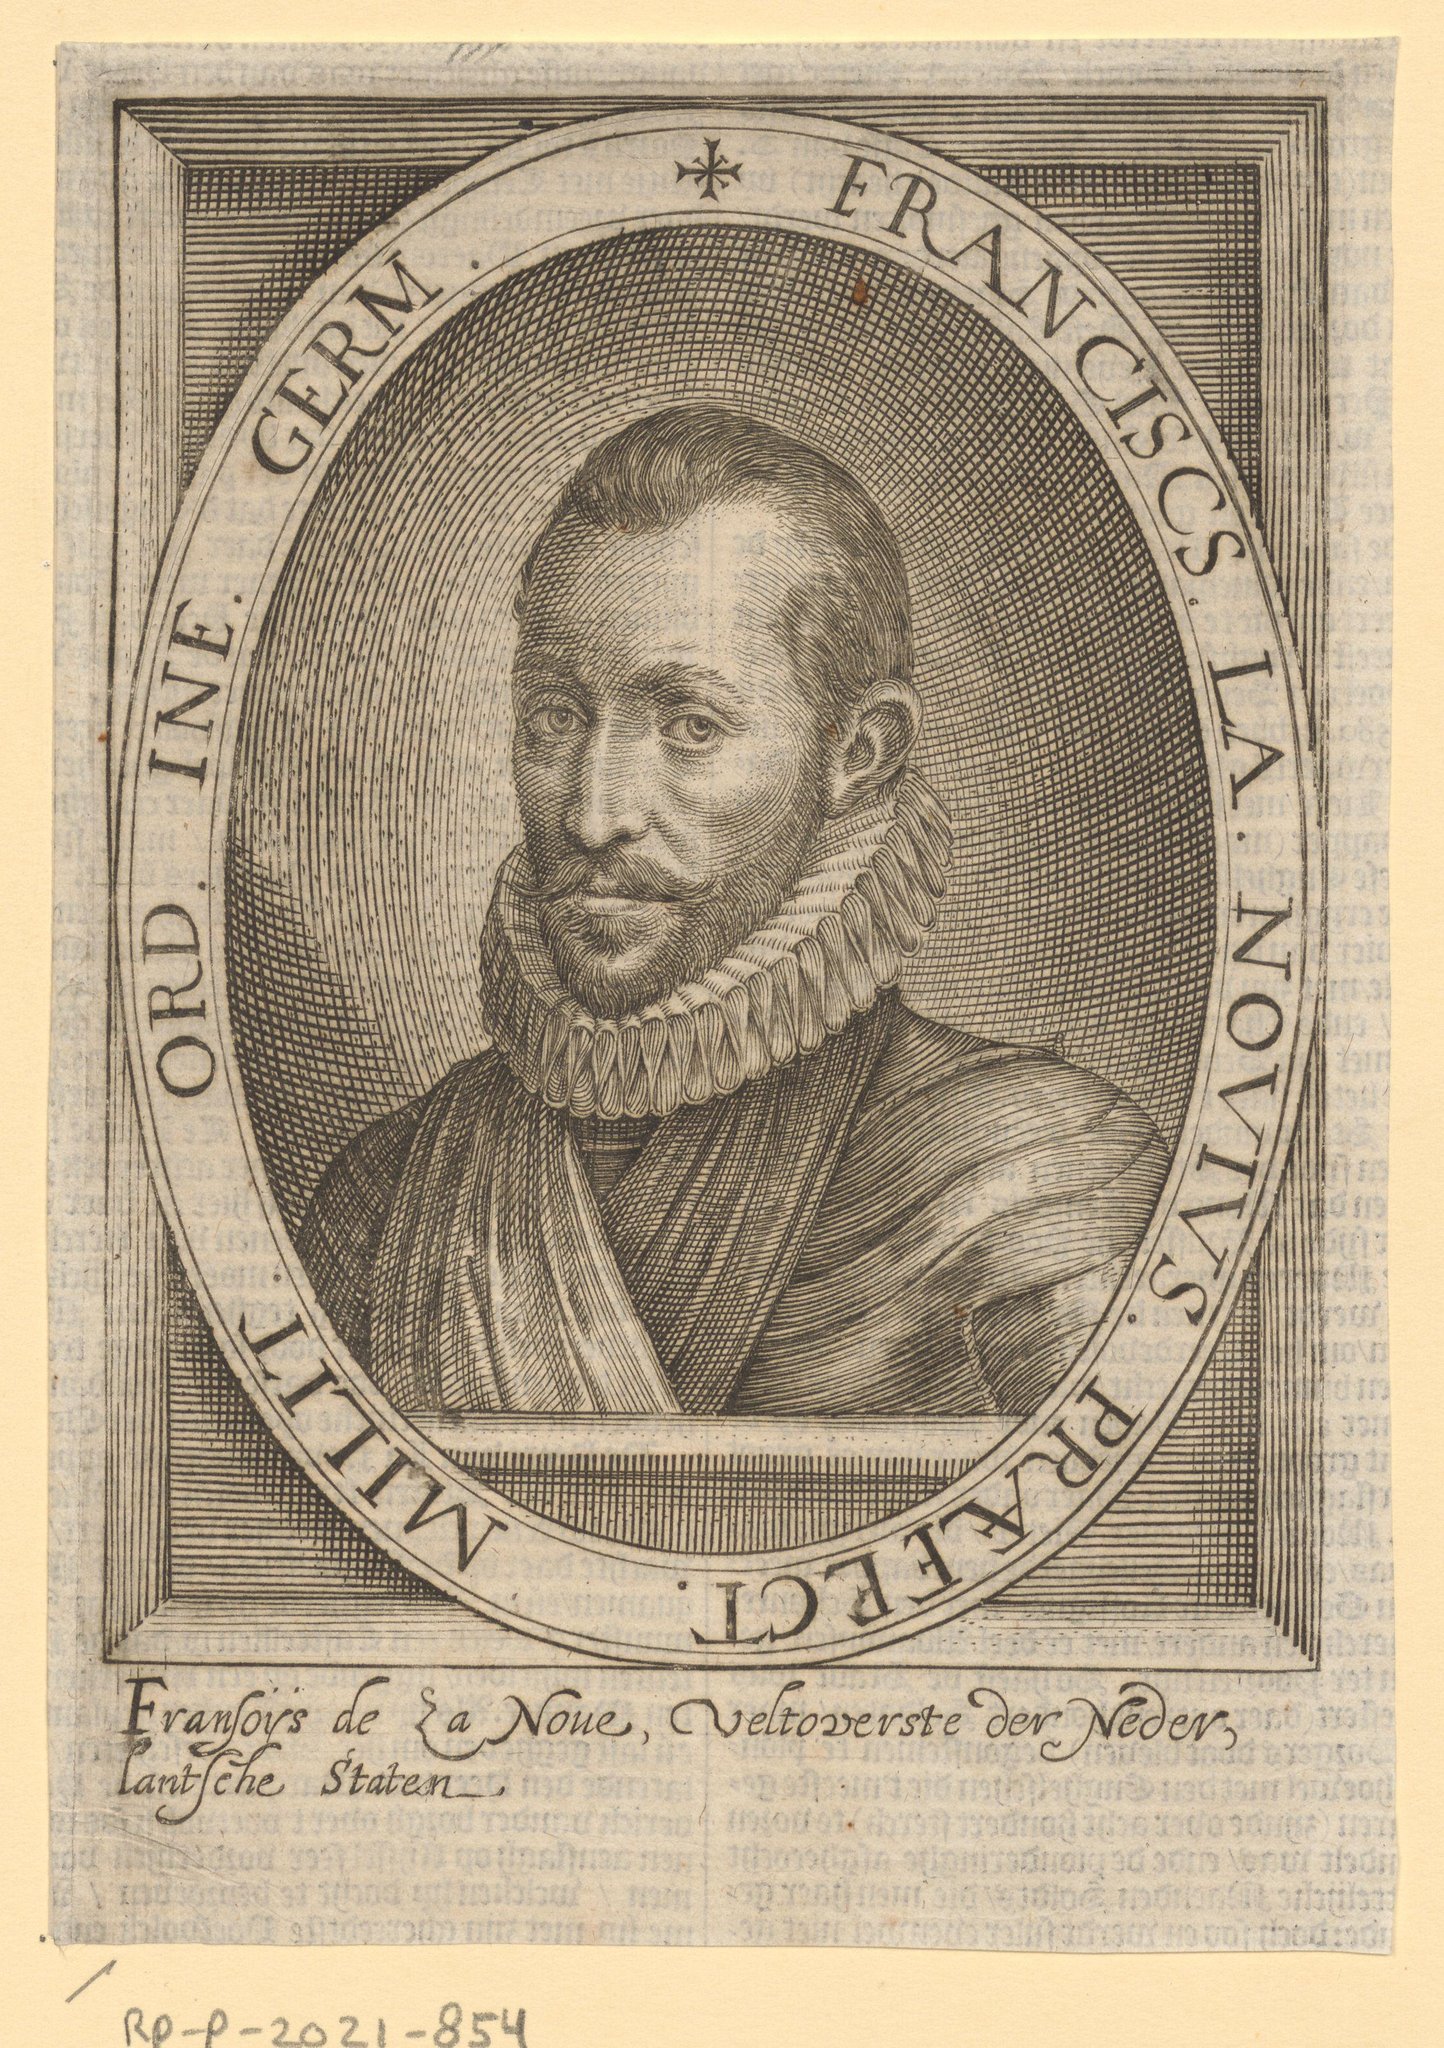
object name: print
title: Portret van François de La Noue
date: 1614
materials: paper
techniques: engraving, letterpress printing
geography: the hague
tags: armour, historical persons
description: Prent uit: Meteren, Emanuel van. Historie der Neder-landscher ende haerder na-buren Oorlogen ende Geschiedenissen. Den Haag: Hillebrant Jacobsz van Wouw, 1614.